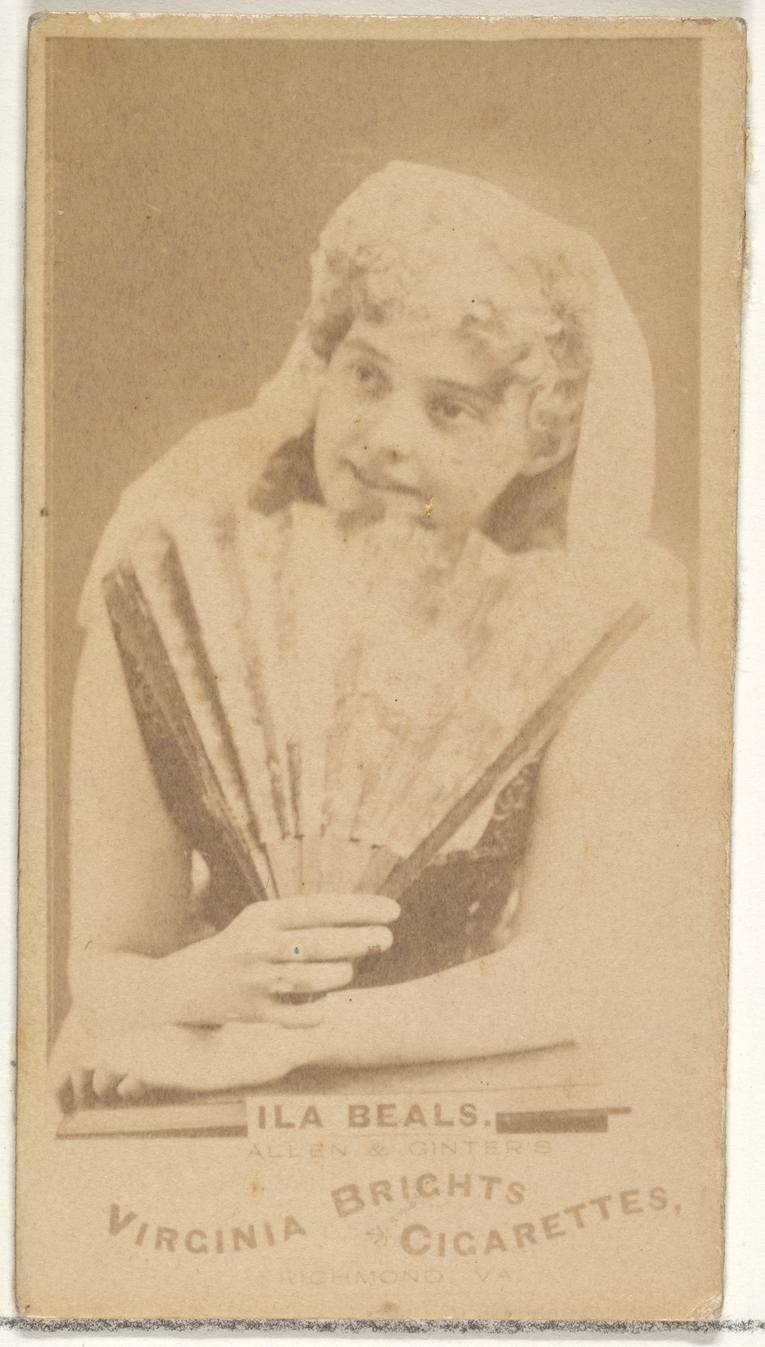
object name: photograph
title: Ila Beals, from the Actors and Actresses series (N45, Type 1) for Virginia Brights Cigarettes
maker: allen & ginter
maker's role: publisher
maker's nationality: american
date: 1888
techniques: albumen silver print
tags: fans,portraits,women,actresses